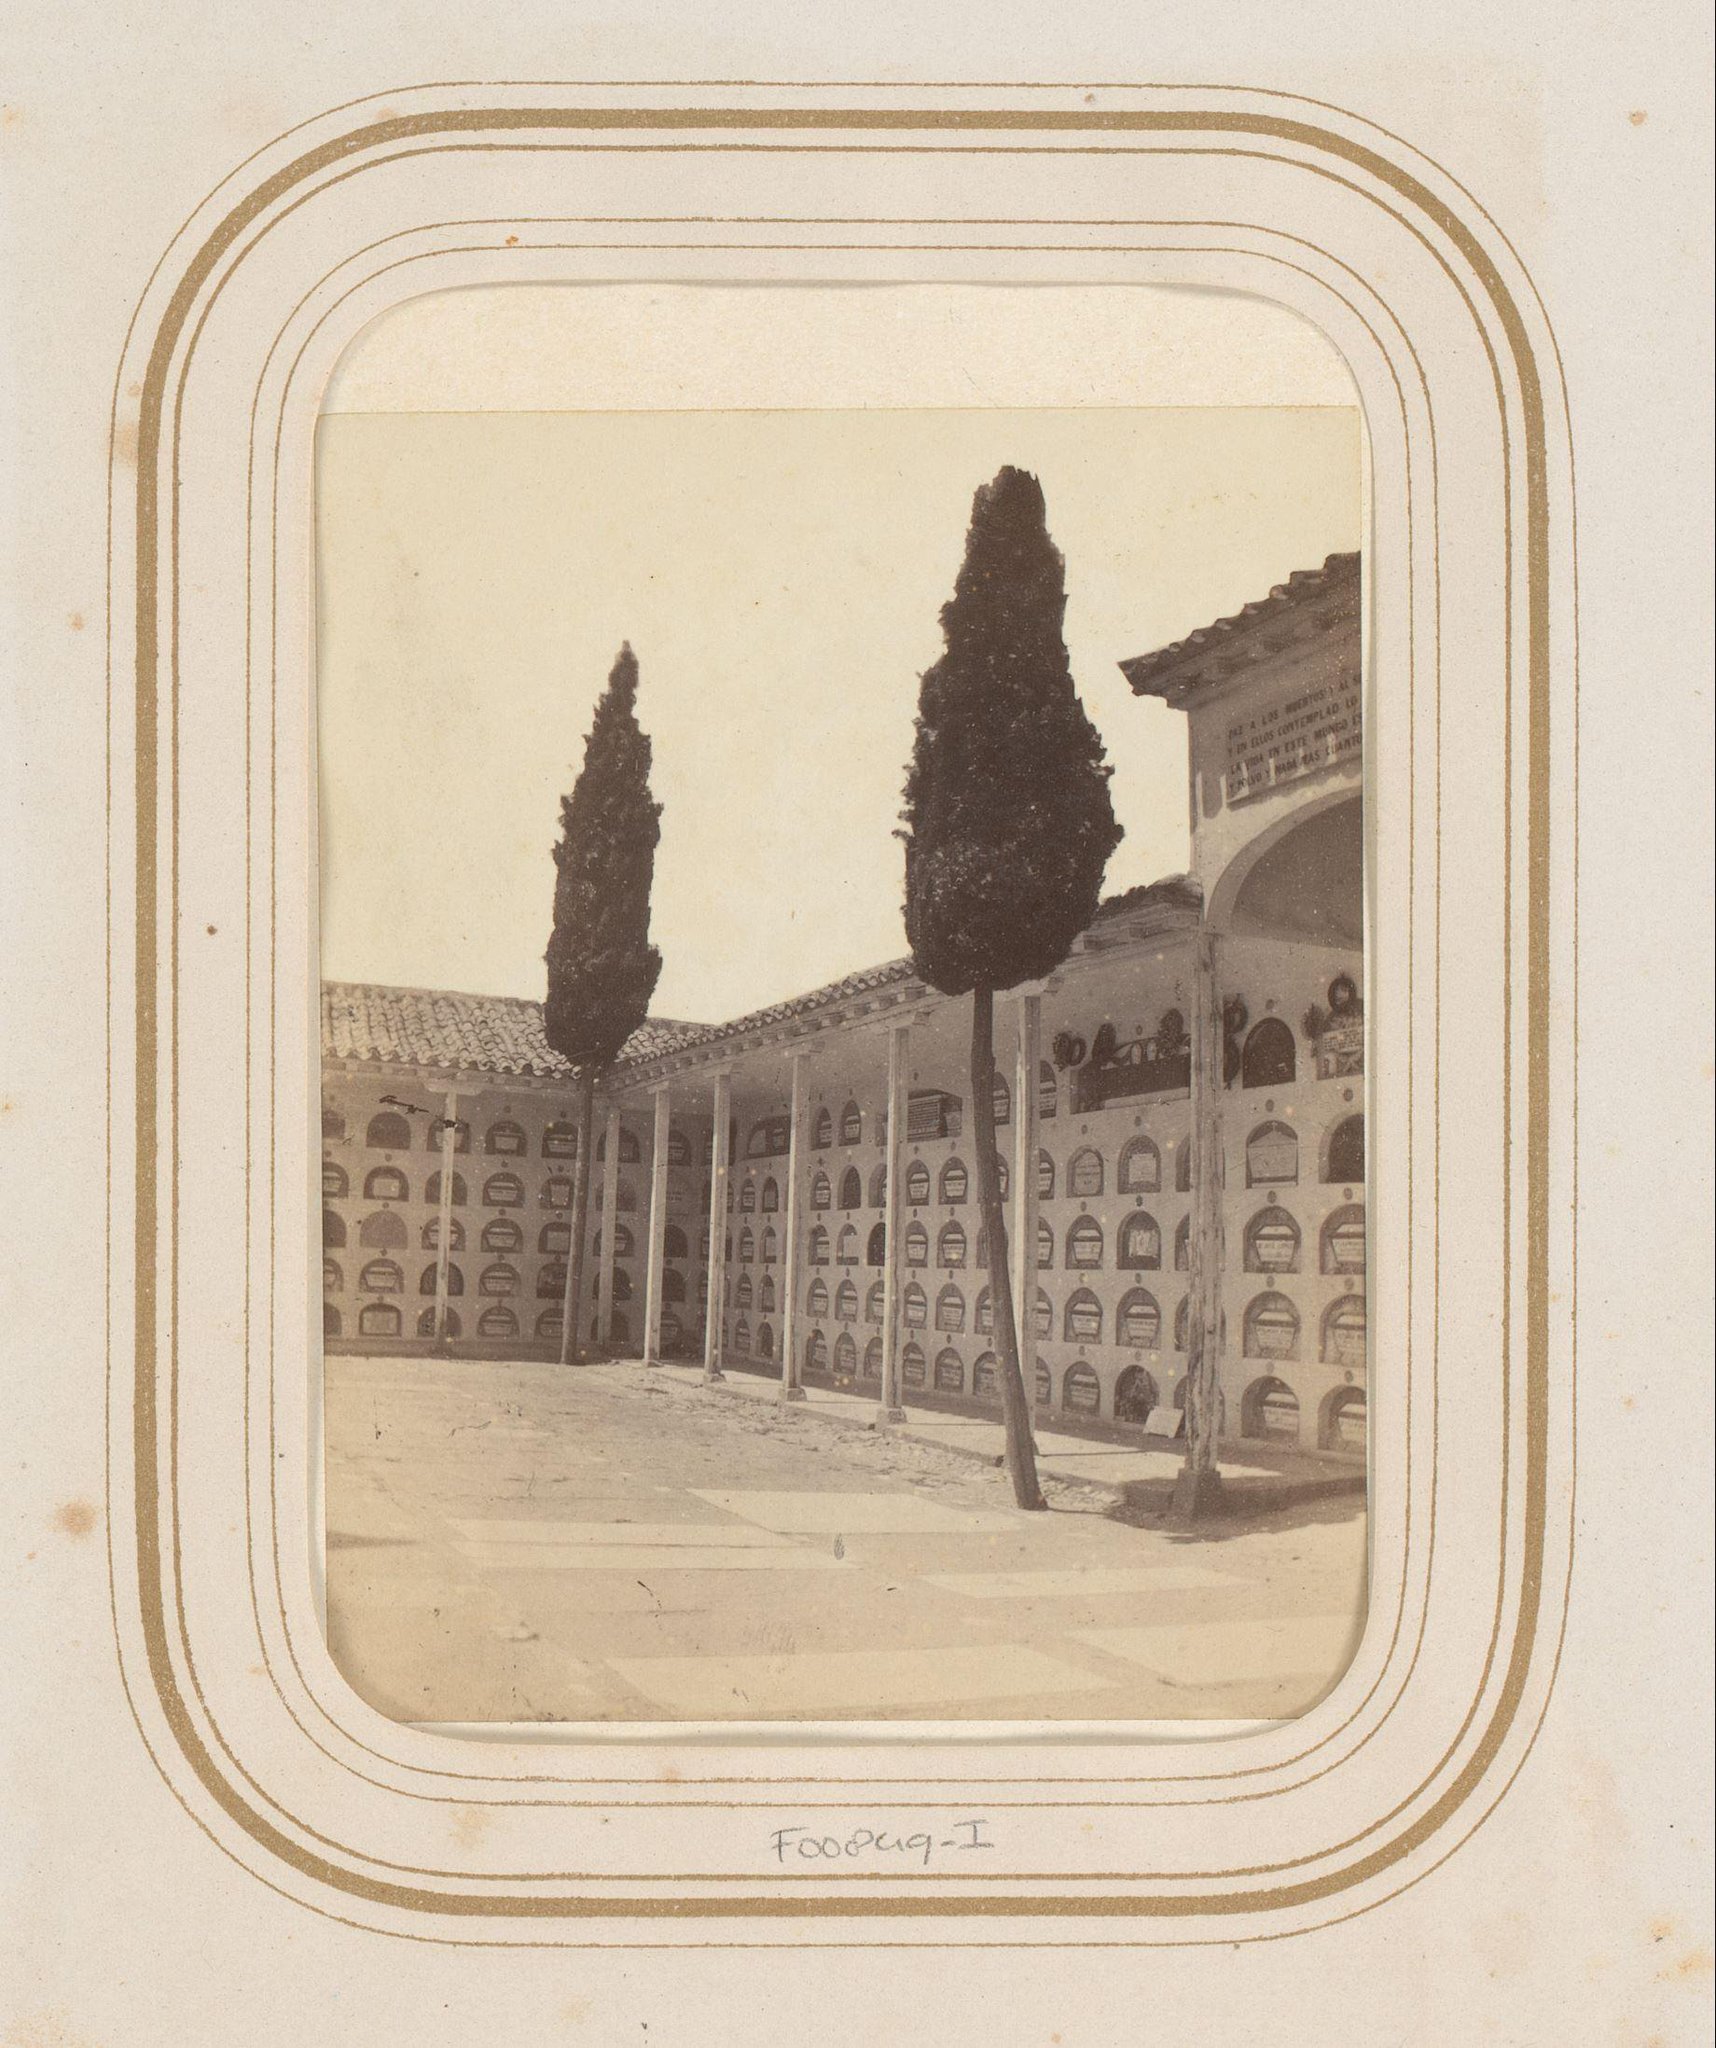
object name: album leaf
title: Gezicht op een urnenwand in Spanje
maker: juan laurent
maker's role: publisher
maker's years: 1816-1896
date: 1857-1880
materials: cardboard, photographic support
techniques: albumen print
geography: spain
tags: urn, churchyard, cemetery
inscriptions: inscription: ‘MONUMENTS ET VUES D'ESPAGNE/ J. LAURENT, Fotog. / Dépot Central./ 39, Carrera S. Geronimo, MADRID/ 27, Rue Richelieu, PARIS’